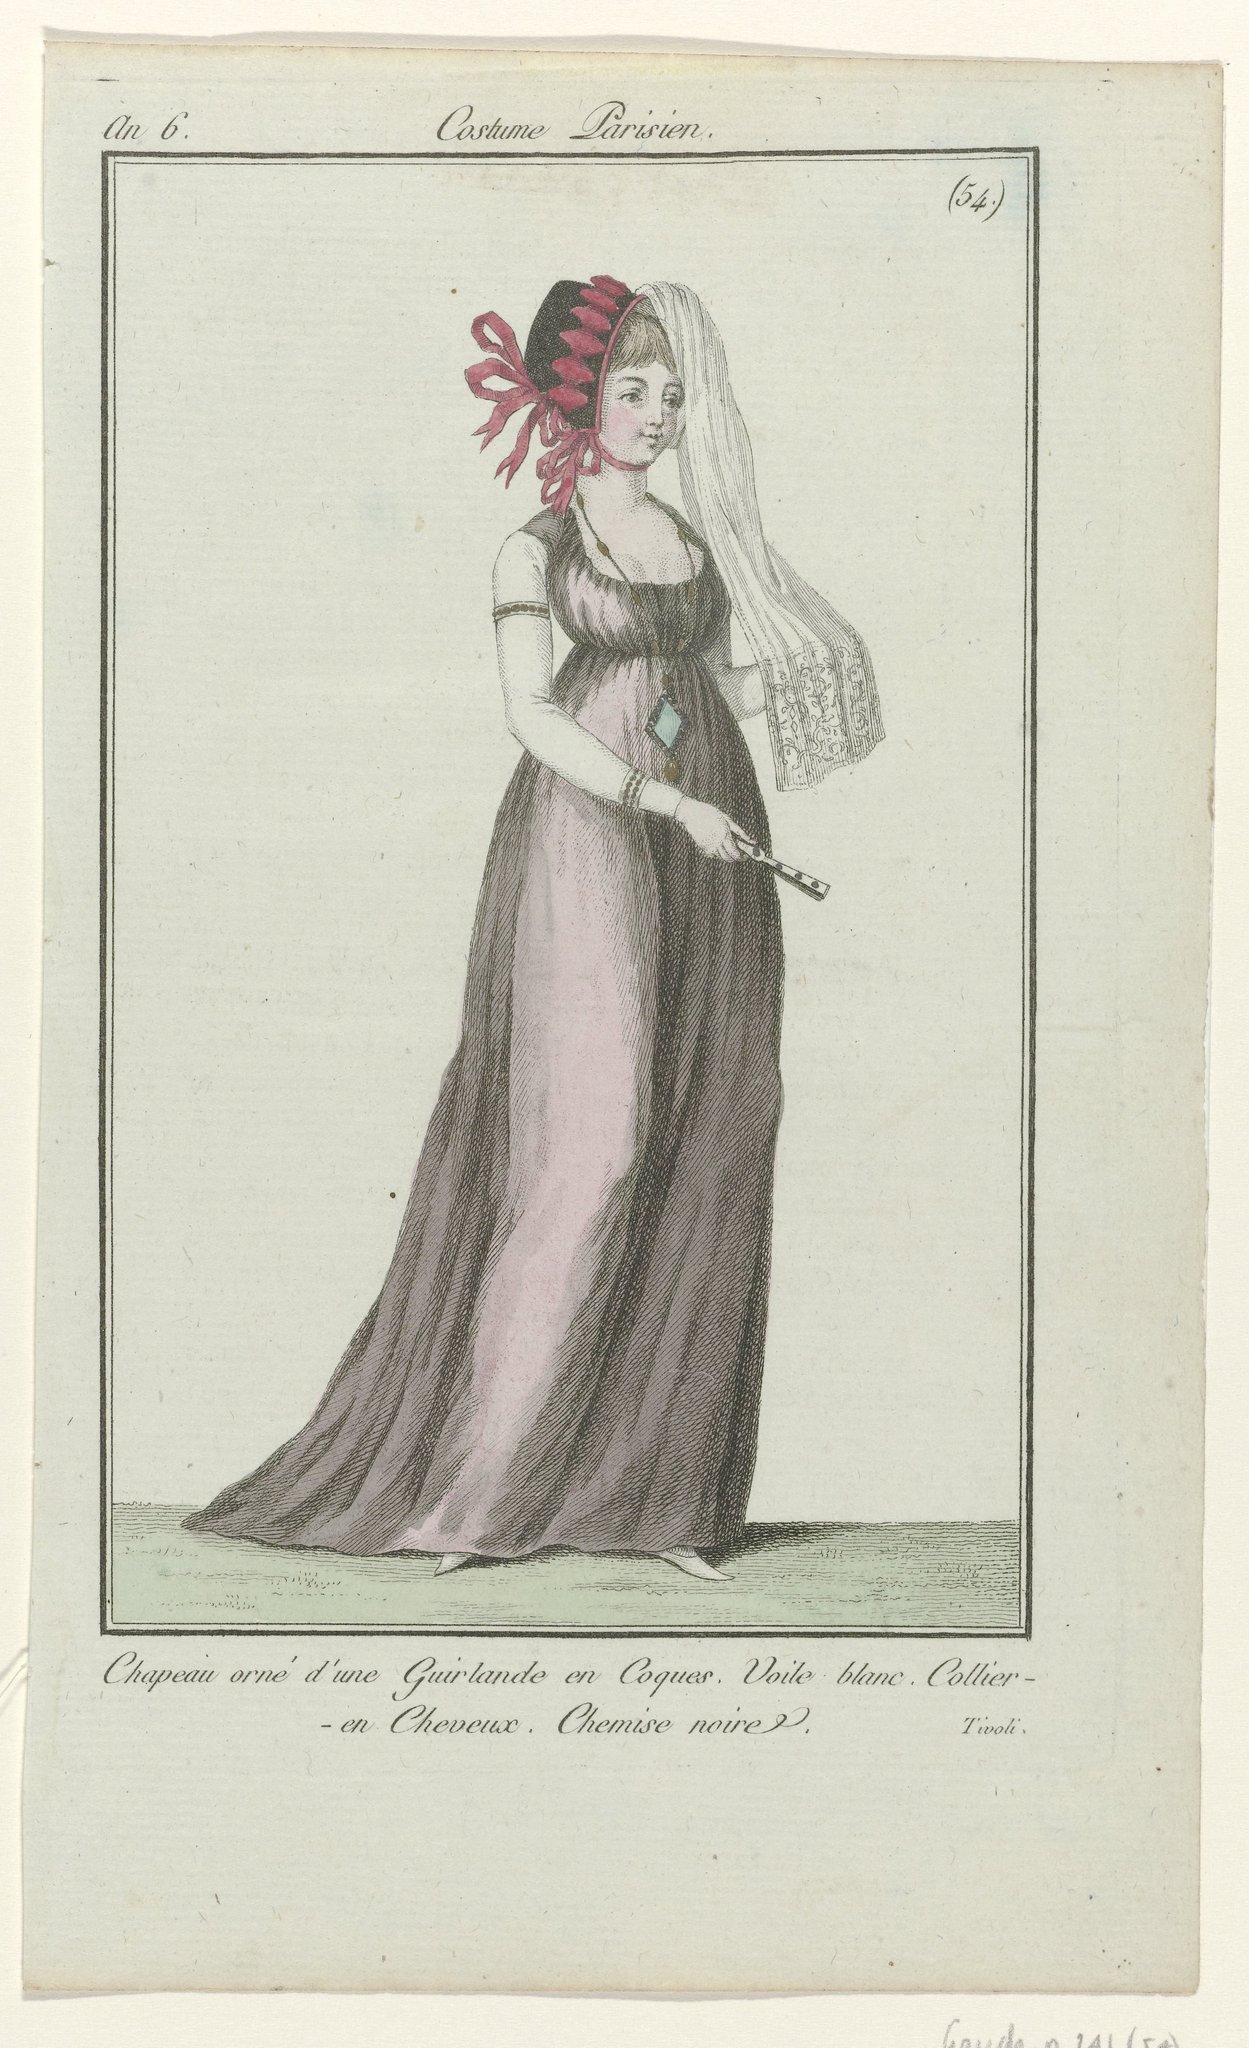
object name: fashion print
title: Journal des Dames et des Modes, Costume Parisien, 7 août 1798, An 6, (54) : Chapeau orné d'une Guirland (...)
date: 1798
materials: paper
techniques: engraving, hand coloring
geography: paris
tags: bow (ornamental part of clothing) (+ women's clothes), veil (+ women's clothes), dress, gown: chemise à la reine (+ women's clothes), fashion plates, head-gear: hat (+ women's clothes), fan (+ women's clothes), necklace (+ women's clothes)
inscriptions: caption: ‘Tivoli.’, caption: ‘Chapeau orné d'une Guirlande en Coques. Voile blanc. Collier - en Cheveux. Chemise noire.’, title: ‘Costume Parisien.’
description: Hoed versierd met een guirlande van strikken of 'coques'. Witte sluier. Om de hals een collier van haar (?). Zwarte 'chemise'. Volgens het onderschrift is deze voorstelling naar het leven getekend in 'Tivoli'. De prent maakt deel uit van het modetijdschrift Journal des Dames et des Modes, uitgegeven door Sellèque, Parijs, 1797-1839.